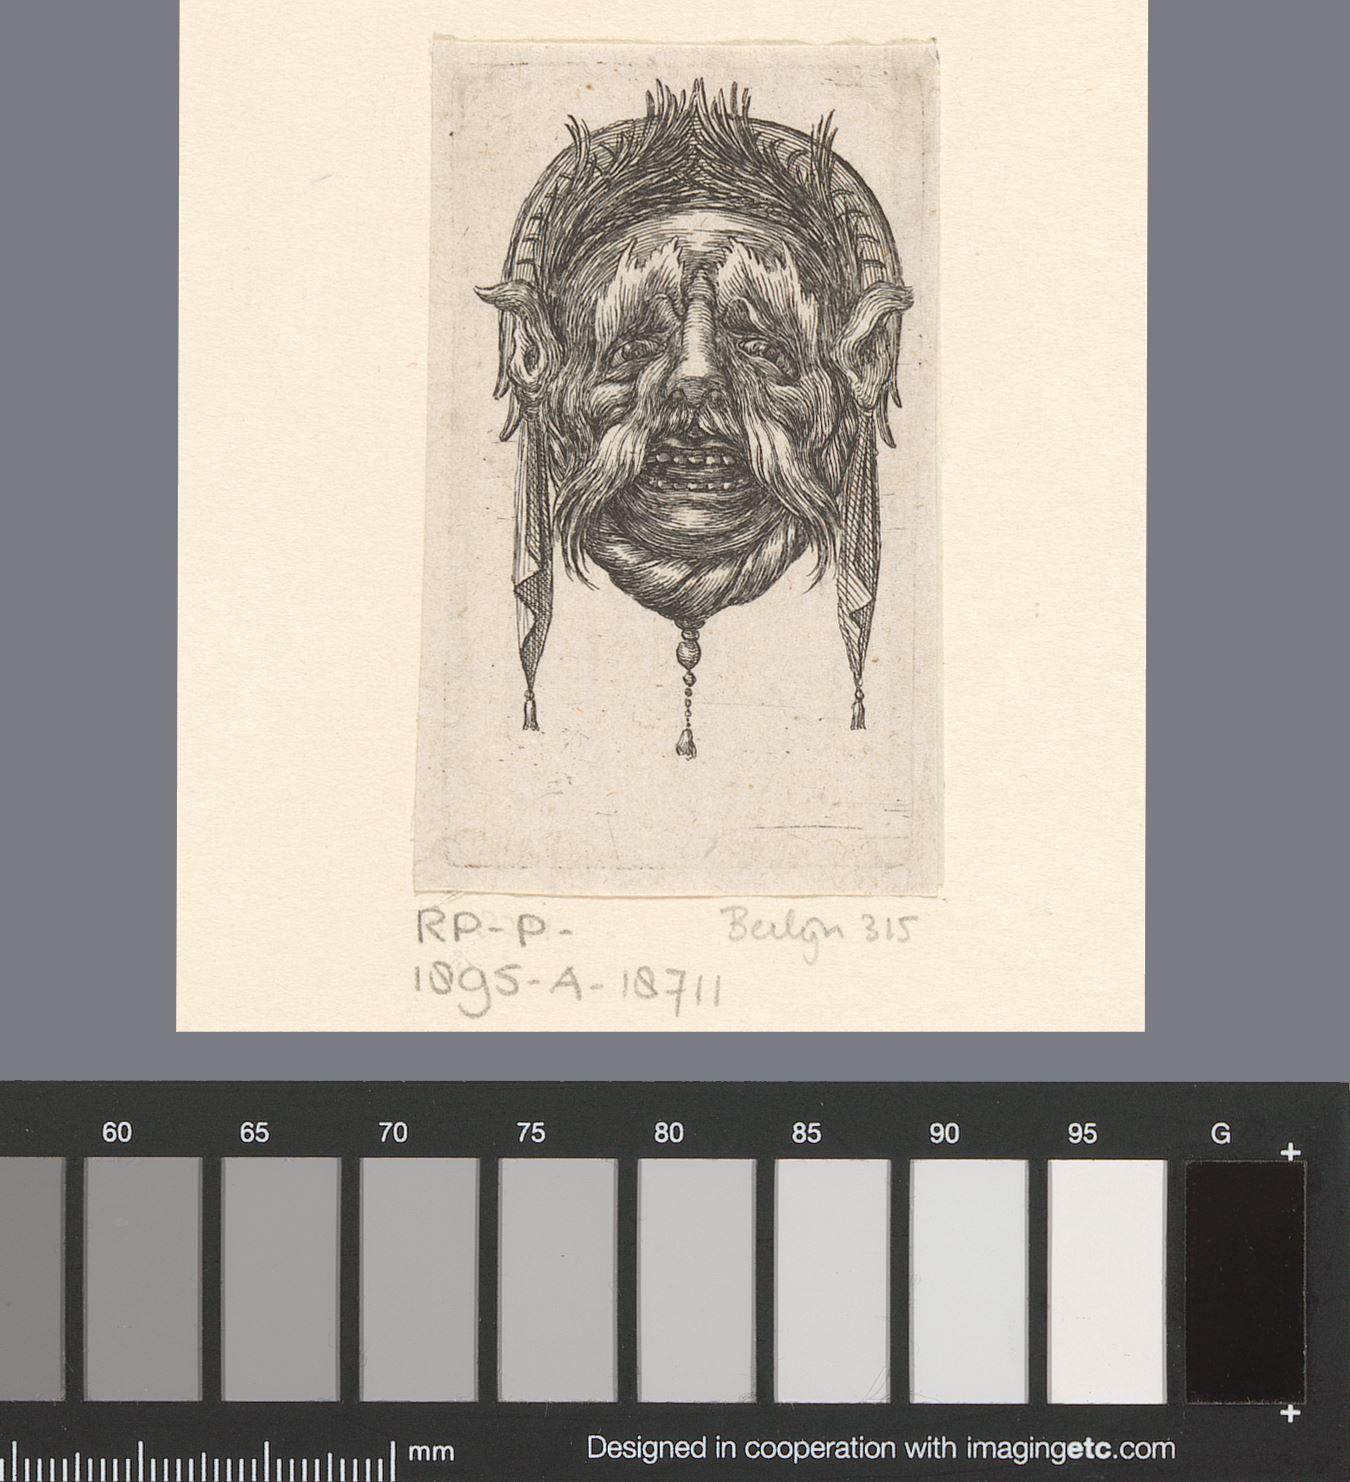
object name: ornament print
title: Masker met snor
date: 1626-1676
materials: paper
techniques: etching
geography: paris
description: Mannelijk masker met een snor en een doek op het hoofd.